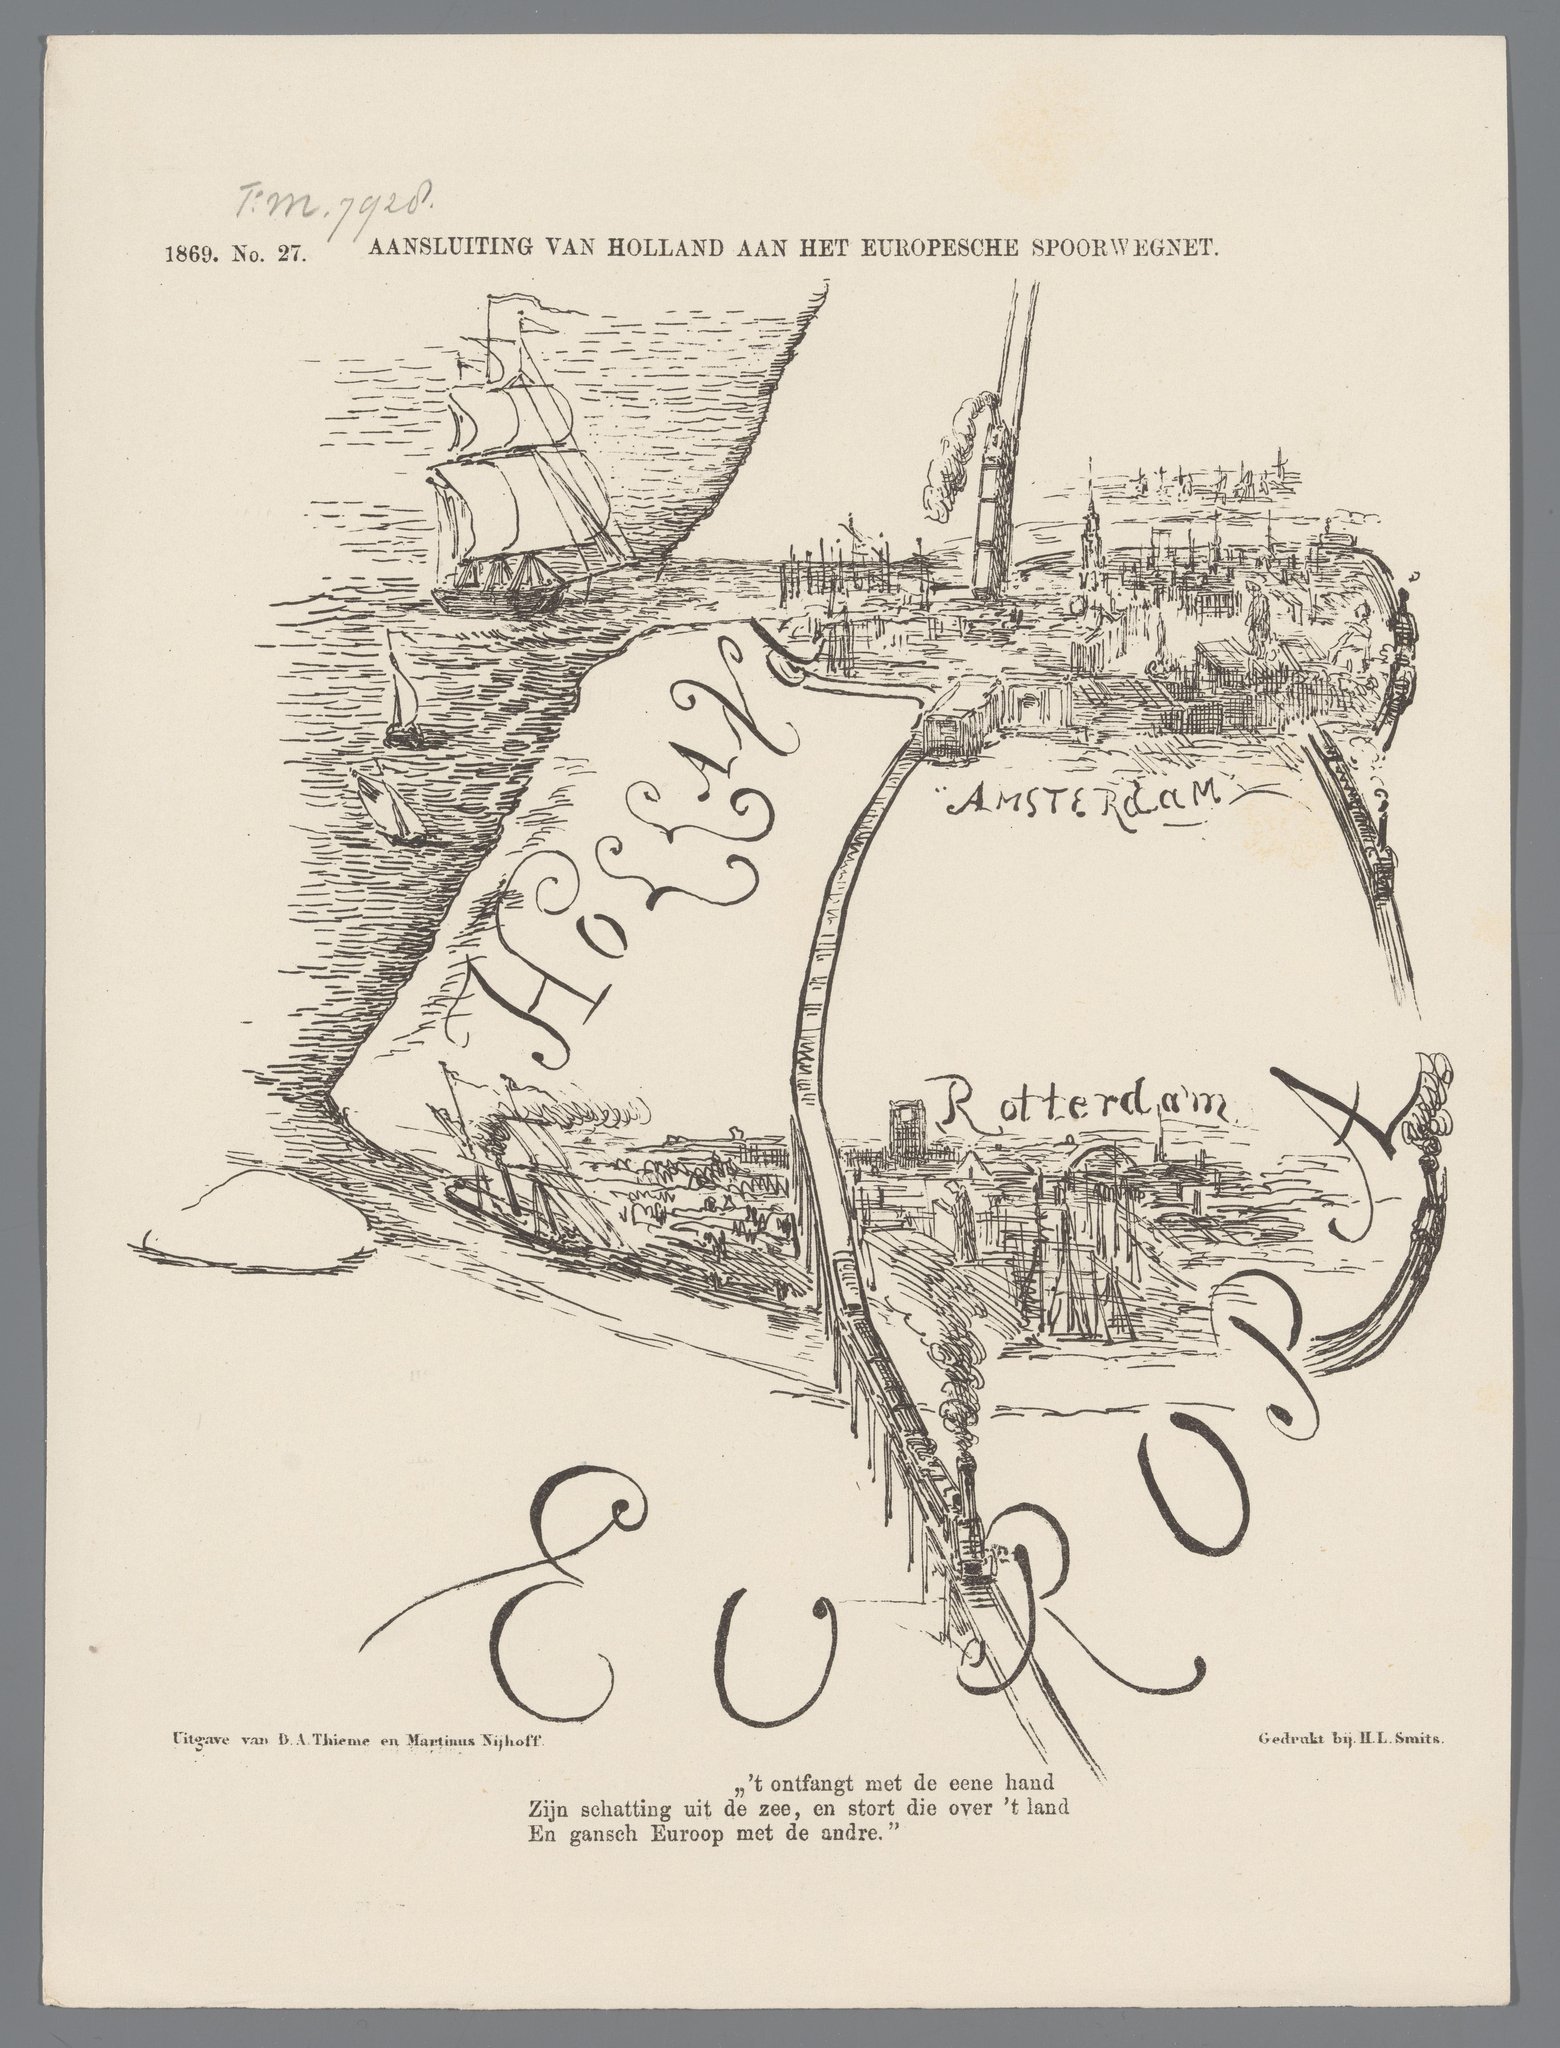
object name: print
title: Spotprent over de rol van Holland binnen Europa, 1869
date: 1869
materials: paper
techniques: lithograph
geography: netherlands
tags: rotterdam, amsterdam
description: Spotprent met een kaart van Holland met het Noordzeekanaal en de spoorverbindingen van Amsterdam en Rotterdam met Europa. Plaat verschenen bij het weekblad De Nederlandsche Spectator, nr. 27, 1869.